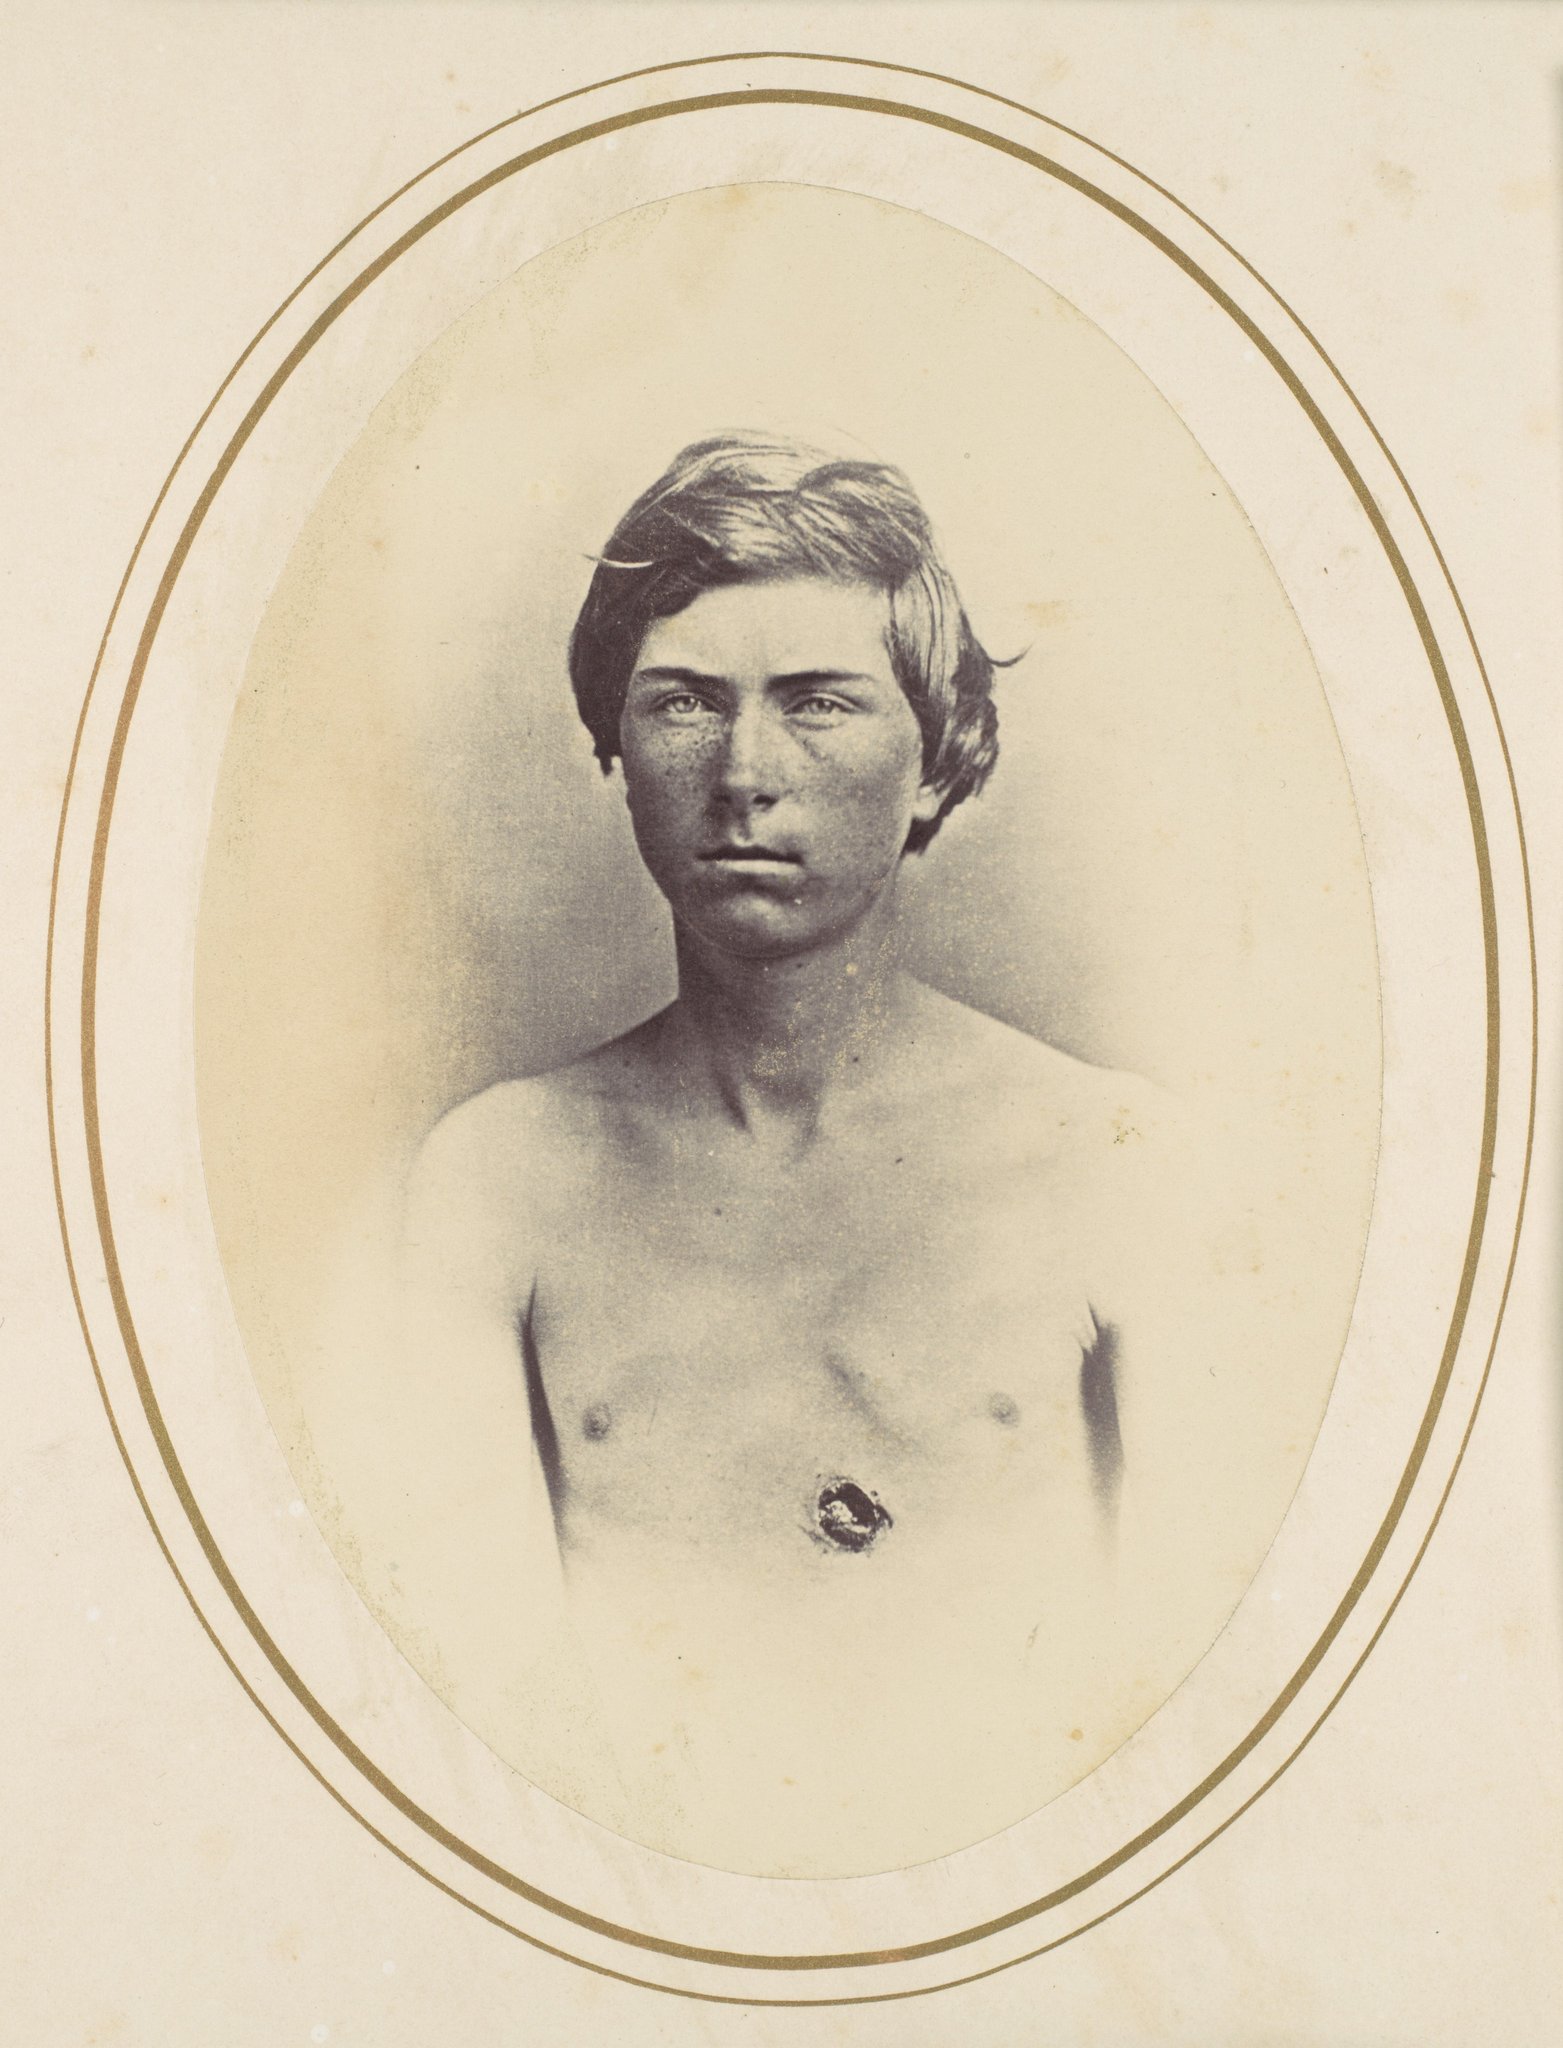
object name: photograph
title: Frederick A. Bentley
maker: reed brockway bontecou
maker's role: artist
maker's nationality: american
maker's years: 1824-1907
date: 1865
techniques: albumen silver print, glass negative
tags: soldiers,american civil war,men,portraits